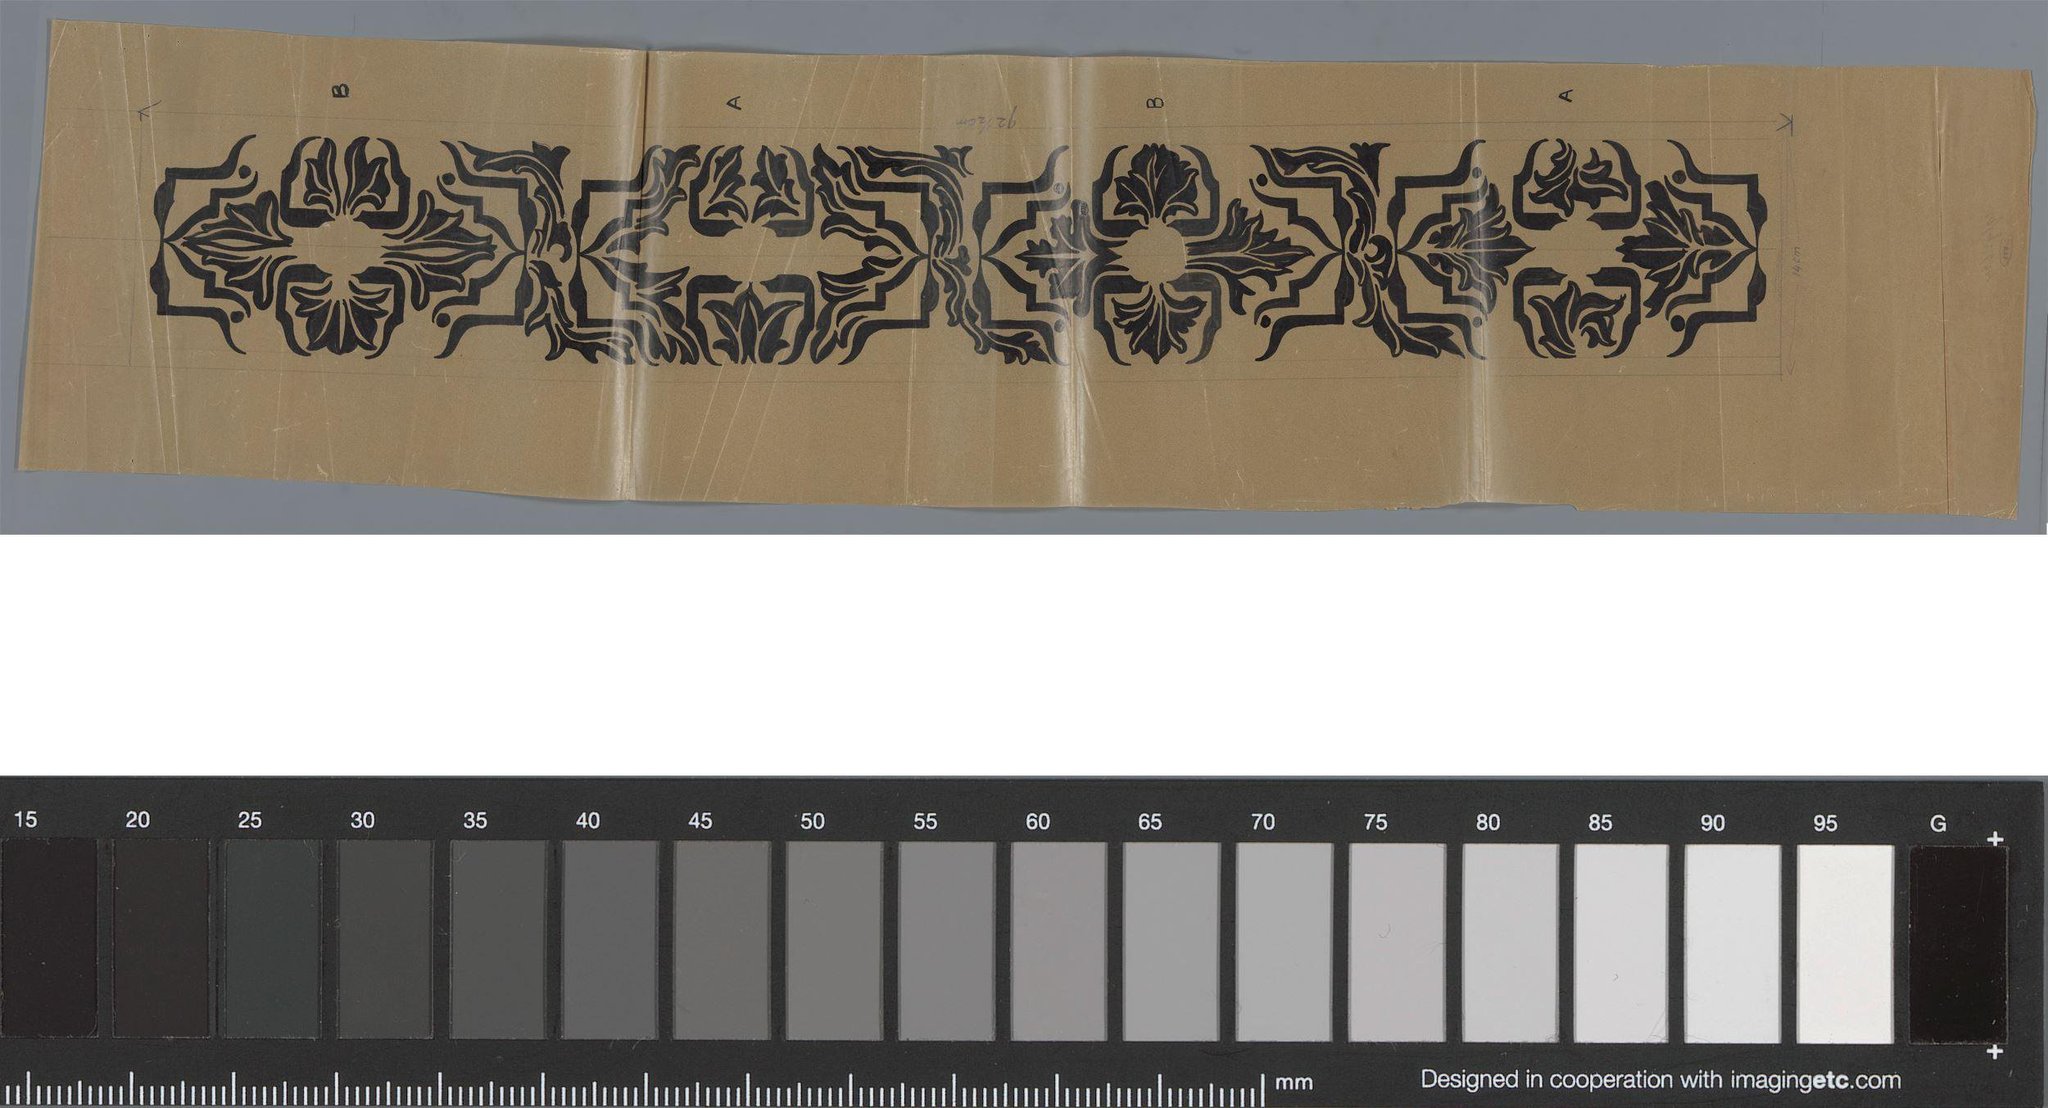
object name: design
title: Ontwerp voor een decoratief paneel, met gestileerde bloemen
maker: carel adolph lion cachet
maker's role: draughtsman, print maker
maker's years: 1864-1945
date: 1874-1945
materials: pencil, paper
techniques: brush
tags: flowers ~ ornament - aa - stylized